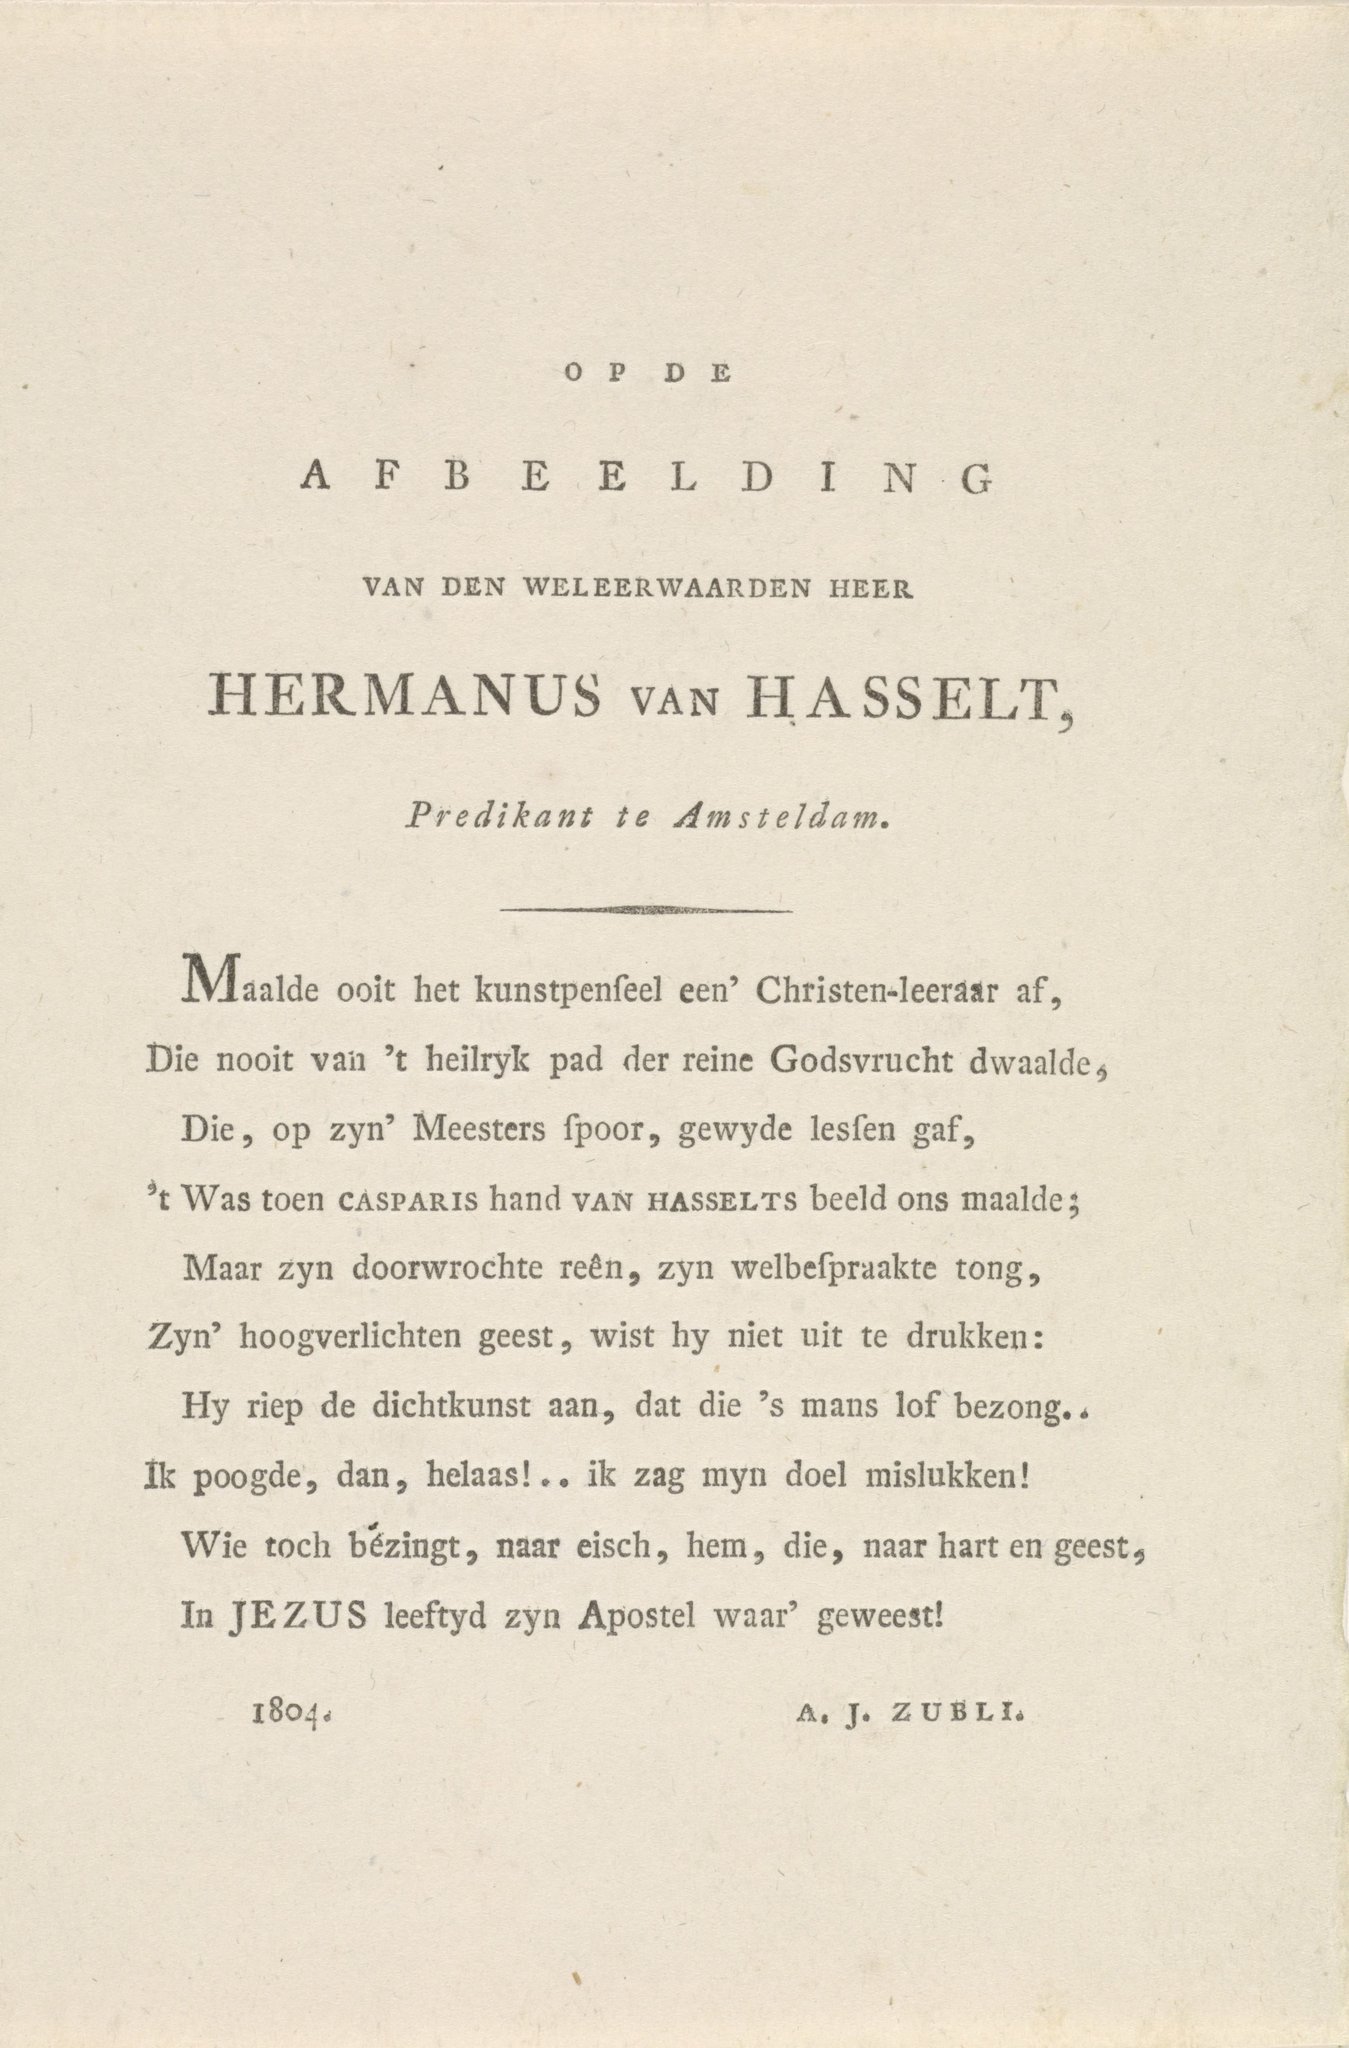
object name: print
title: Tekstblad behorende bij het portret van Hermanus van Hasselt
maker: ambrosius justus zubli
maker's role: schrijver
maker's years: 1751-1820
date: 1804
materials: paper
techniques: letterpress printing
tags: hillegom, predikant, hermanus van hasselt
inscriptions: collector's mark: Lugt 2228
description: Tienregelig gedicht behorende bij het portret van predikant Hermanus van Hasselt.